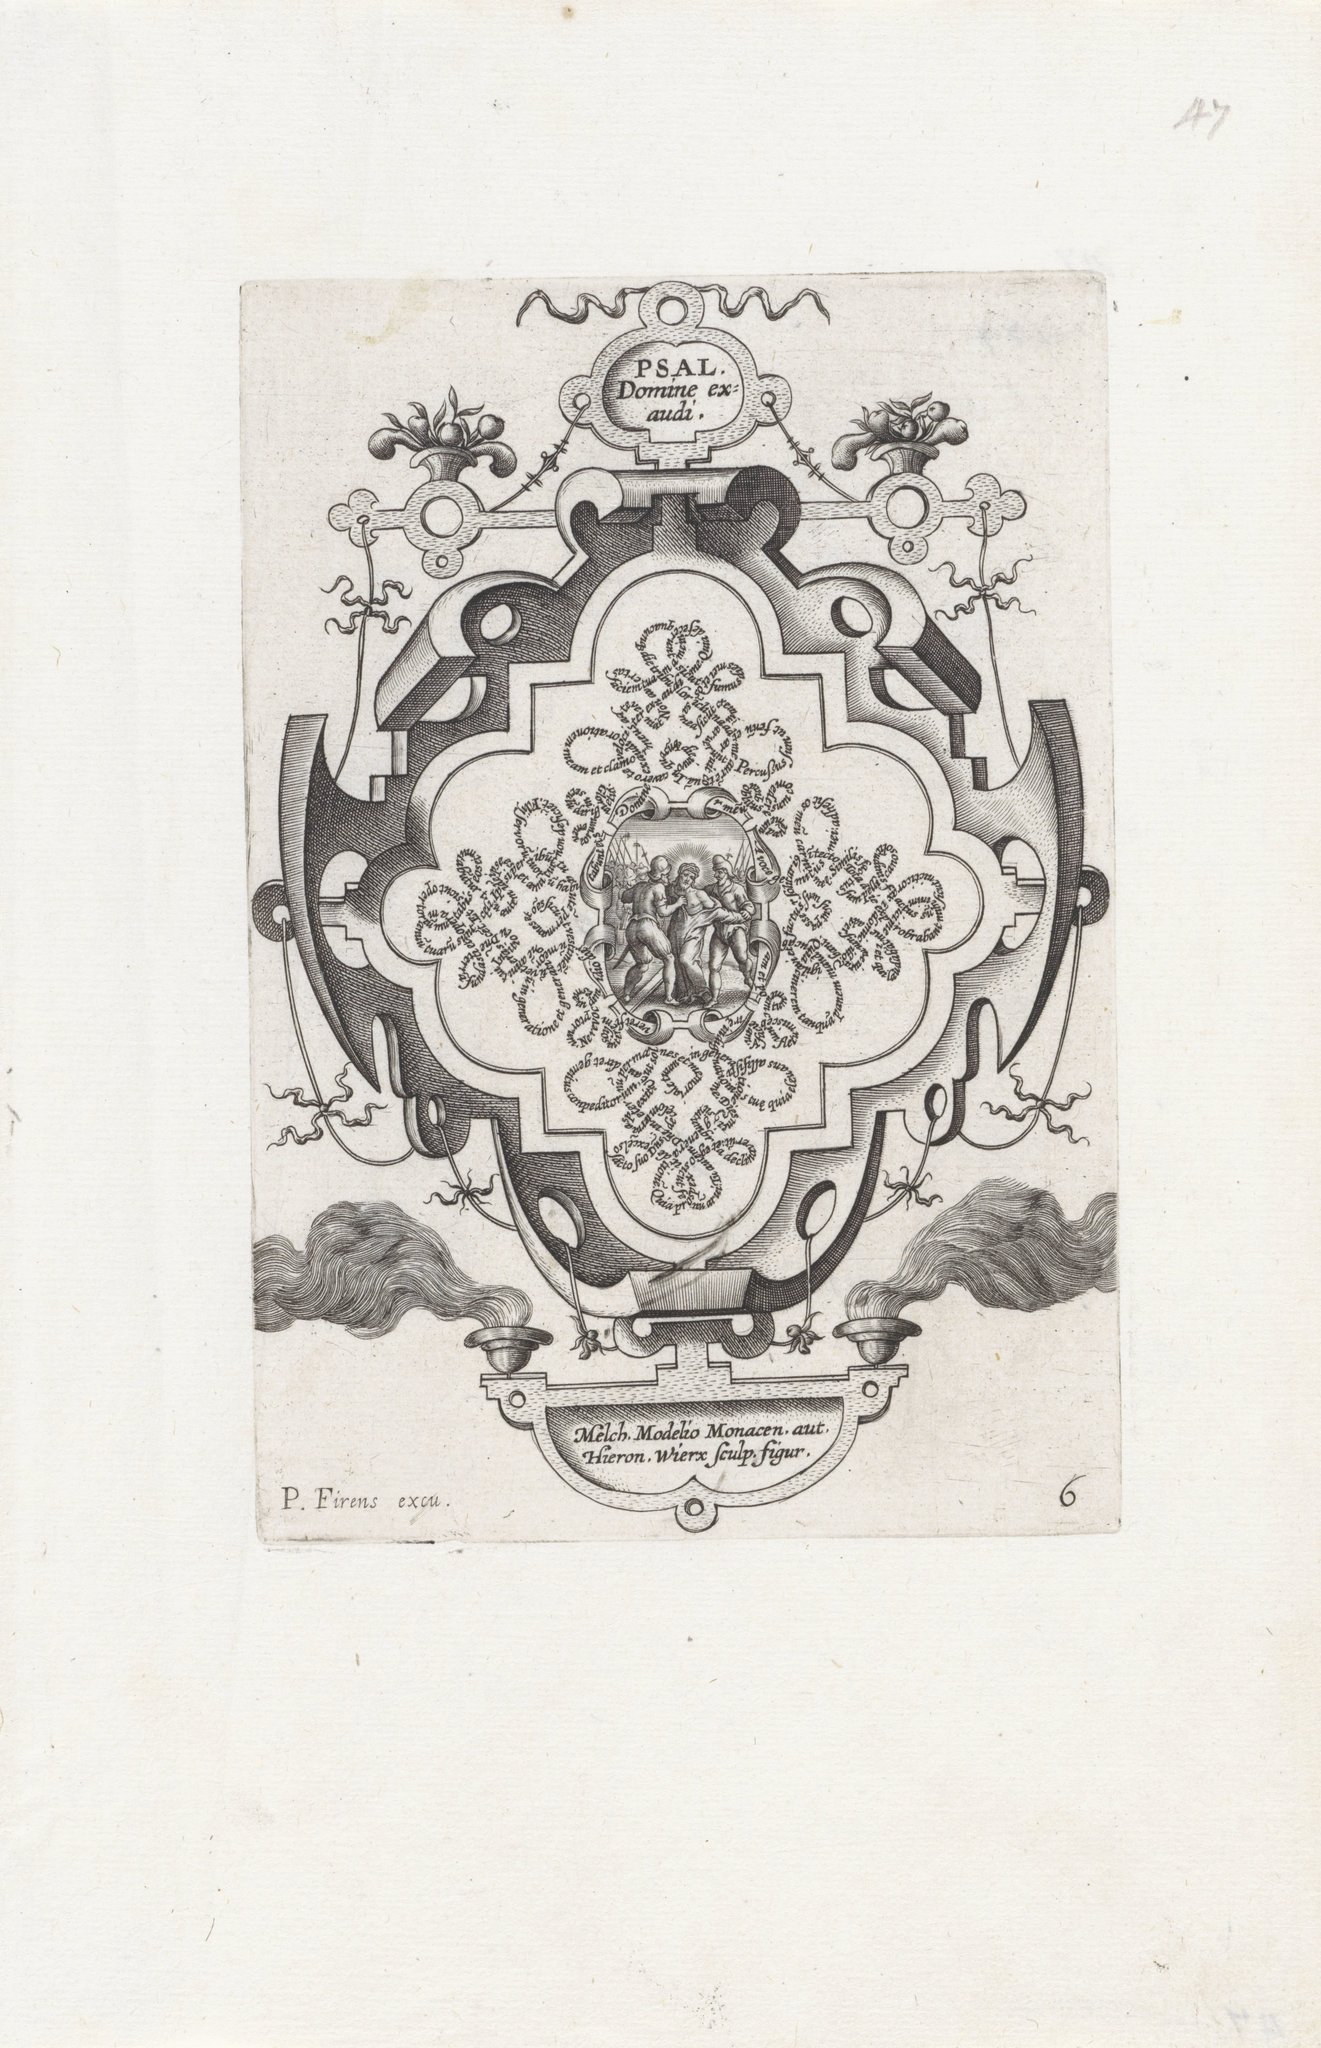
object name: print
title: De zeven boetepsalmen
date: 1608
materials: paper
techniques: engraving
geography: paris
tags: christ disrobed, ornament ~ cartouche, the book of psalms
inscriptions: collector's mark: Lugt 2760, collector's mark: Lugt 2228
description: Twee soldaten rukken de kleren van Christus' lijf. De voorstelling is gevat in een cartouche en geplaatst te midden van de in een knooppatroon gedrukte psalmtekst.